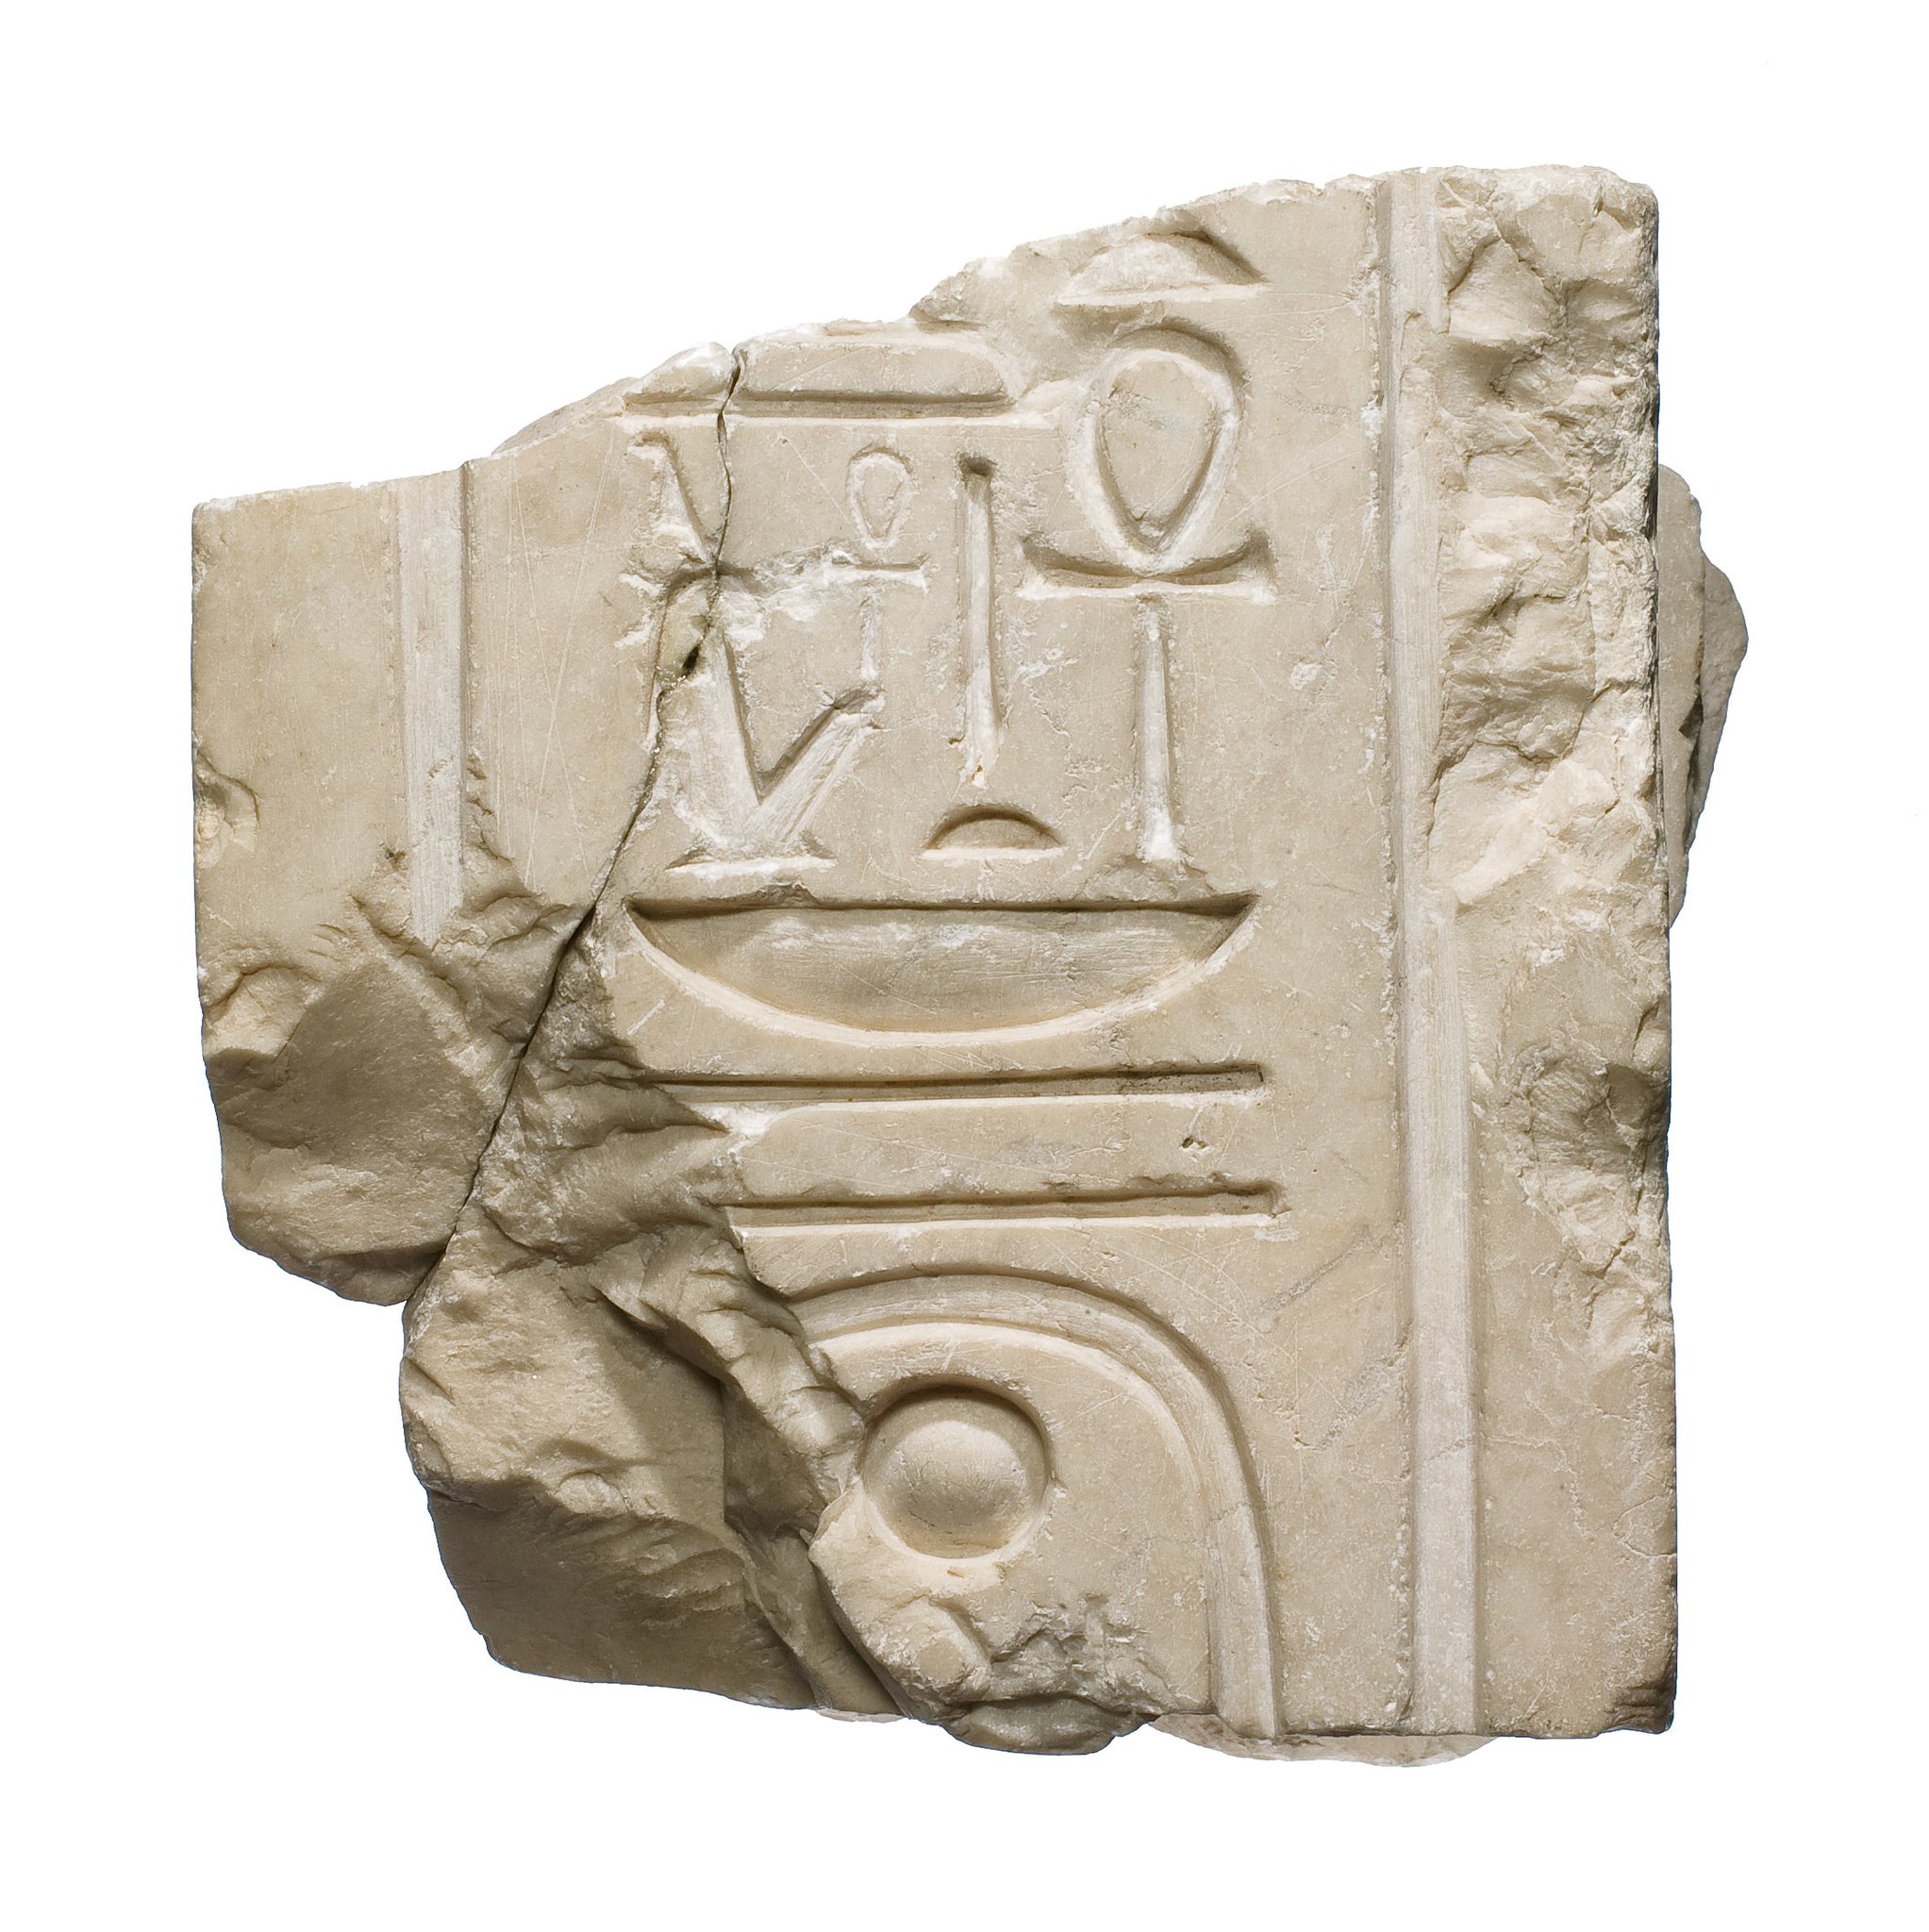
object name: back pillar of torso, with cartouch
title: Back pillar of Torso with titles and cartouche of Akhenaten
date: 1353-1336 BCE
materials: limestone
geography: egypt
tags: hieroglyphs